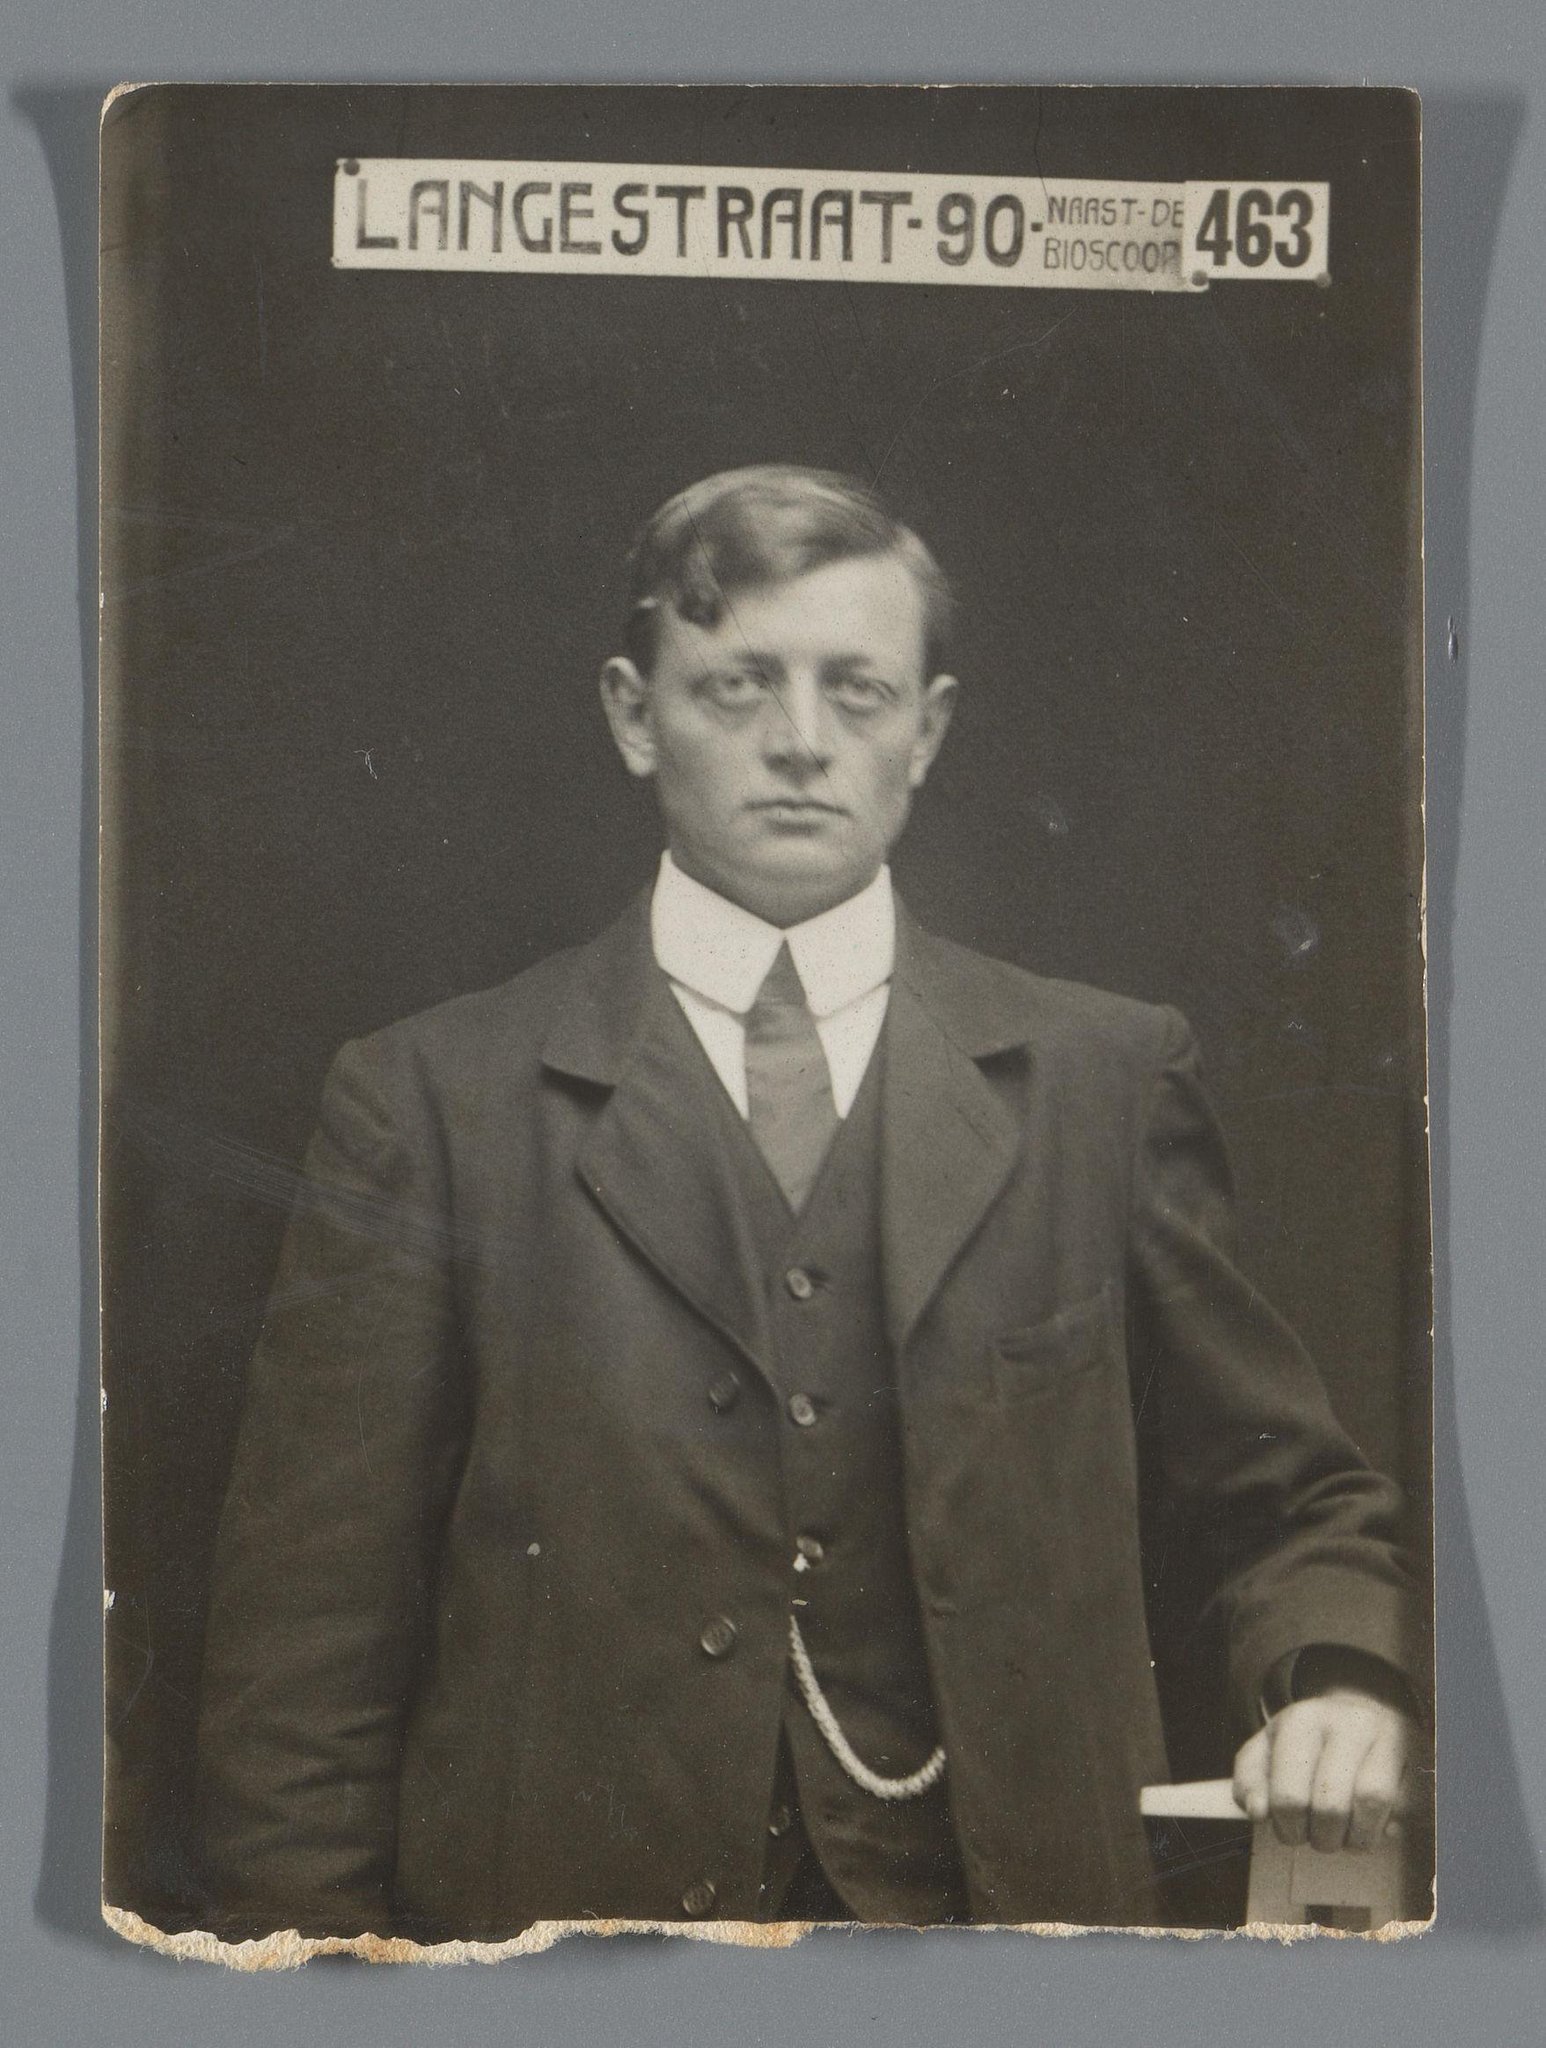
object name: snapshot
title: Portret van een man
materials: photographic support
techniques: gelatin silver print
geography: alkmaar